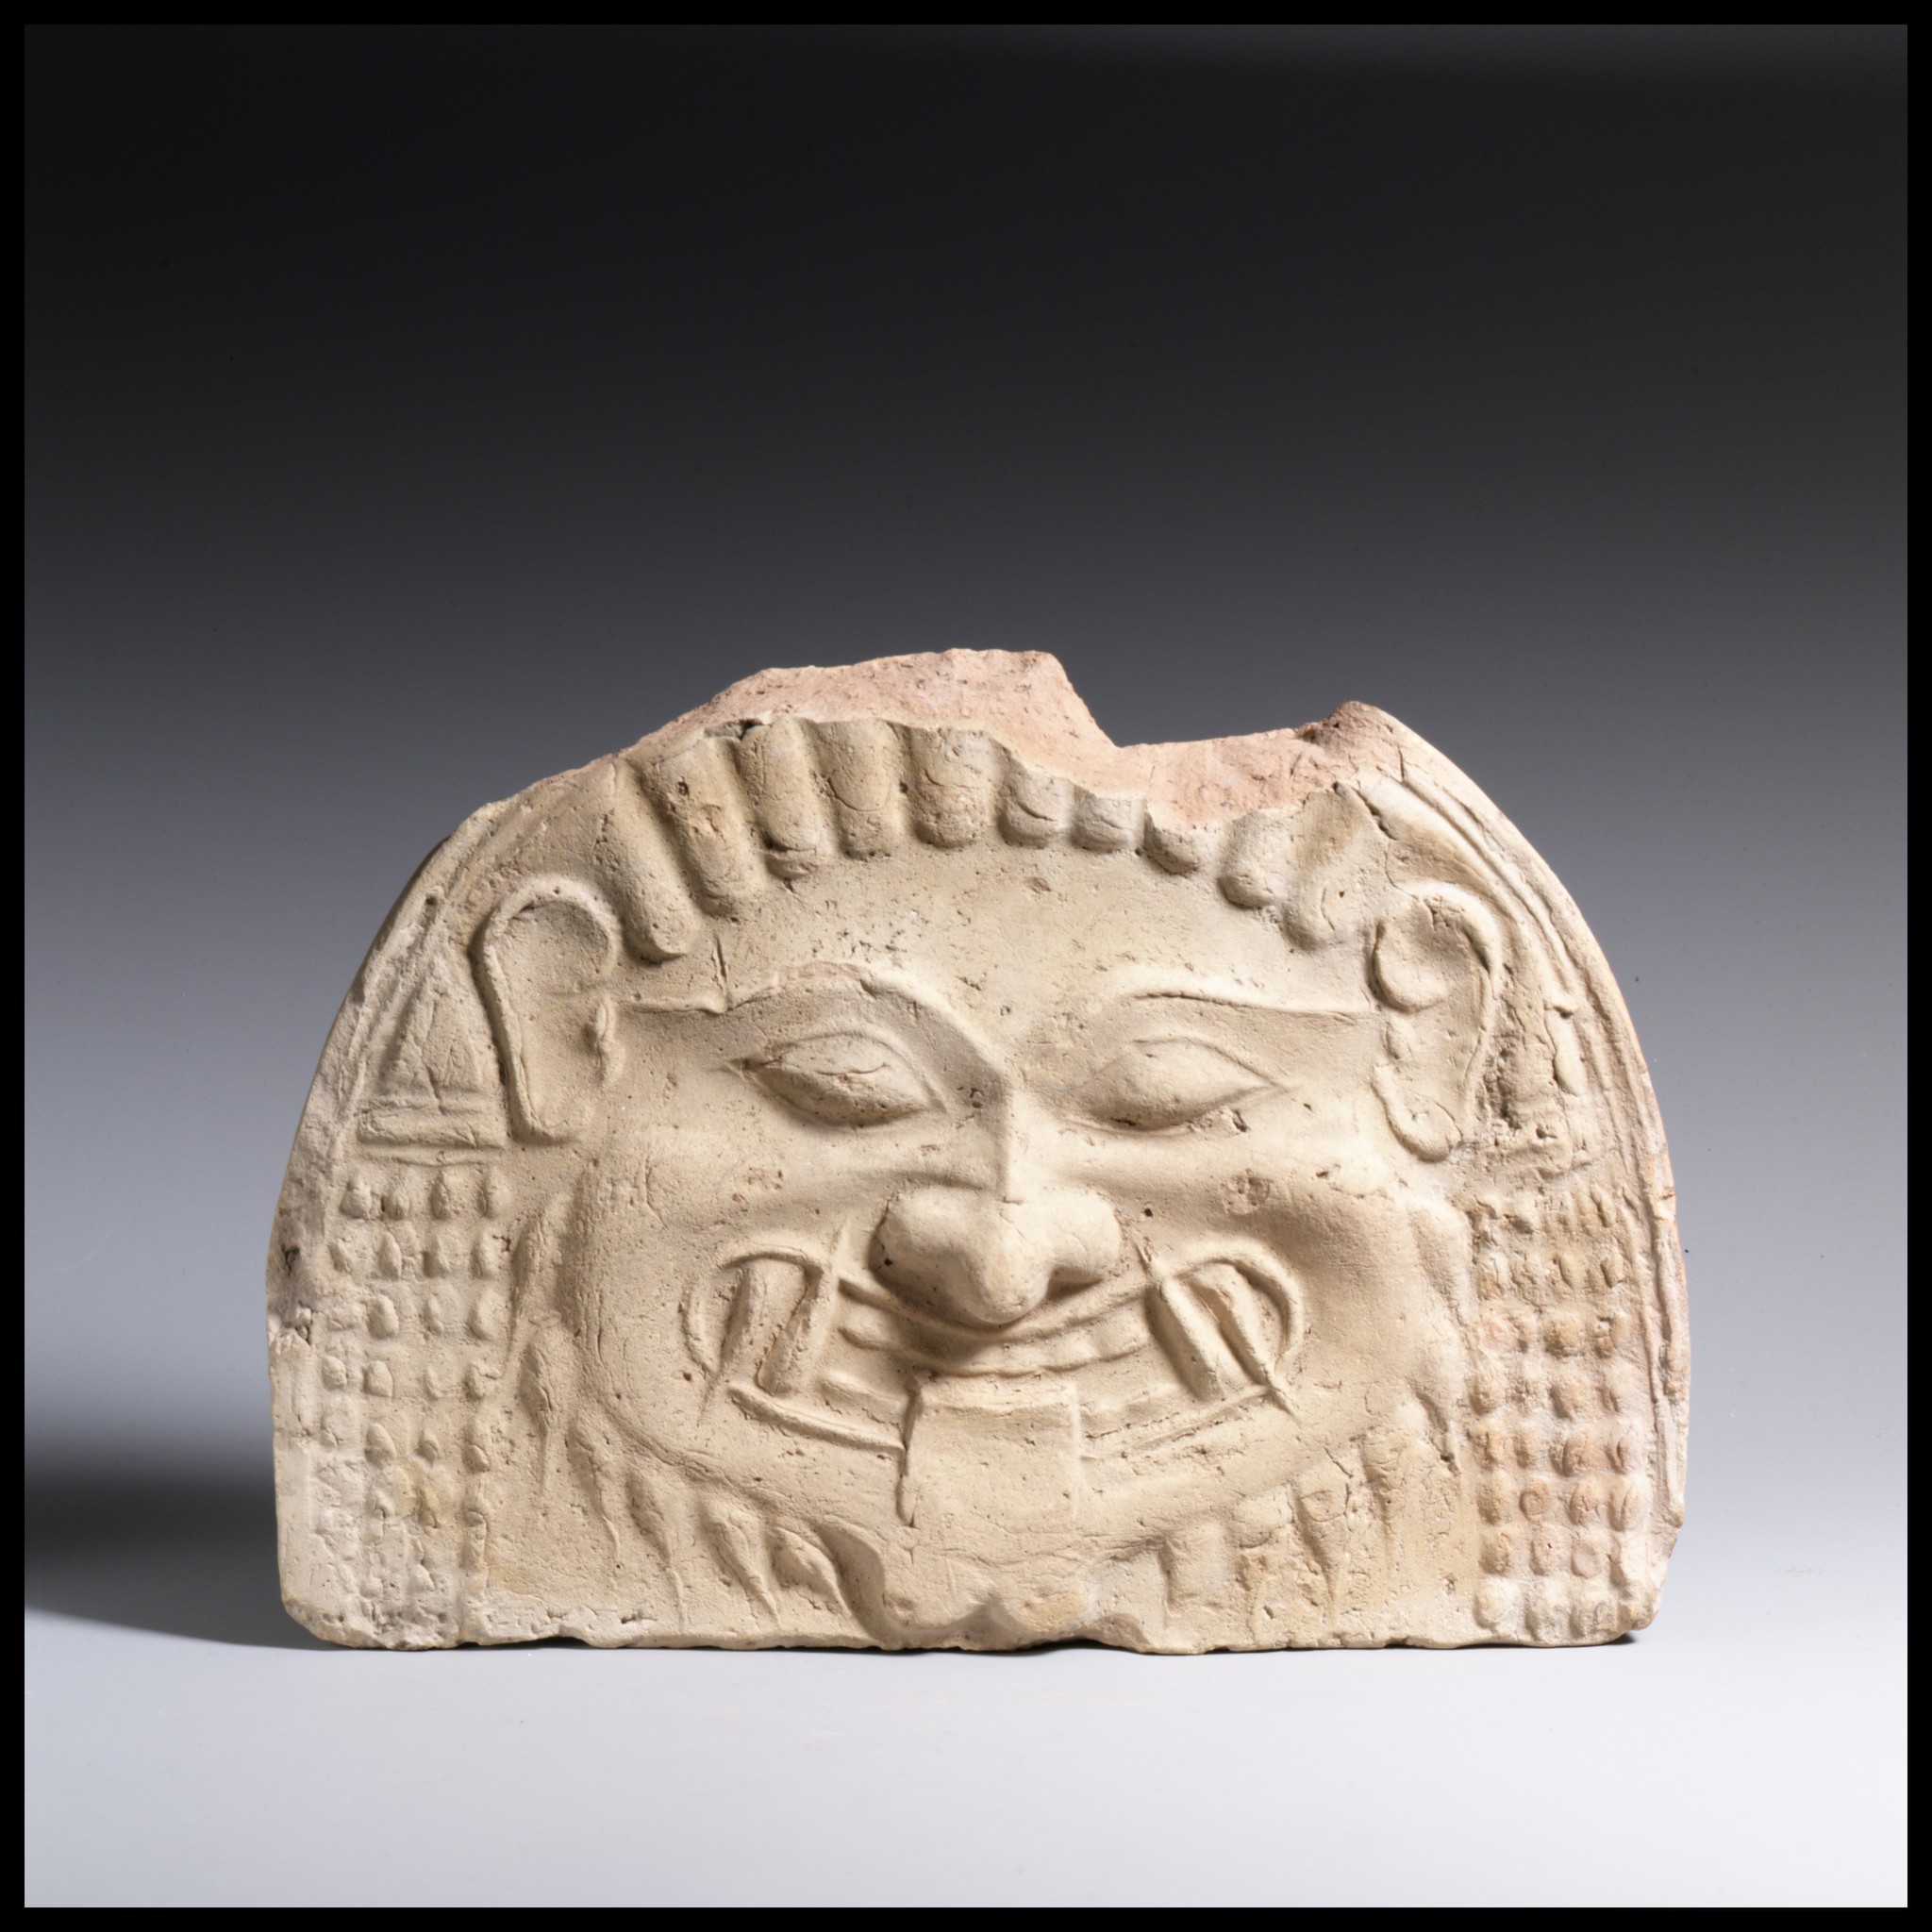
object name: antefix, head of medusa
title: Terracotta gorgoneion antefix (roof tile)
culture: greek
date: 580-570 BCE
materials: terracotta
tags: gorgons